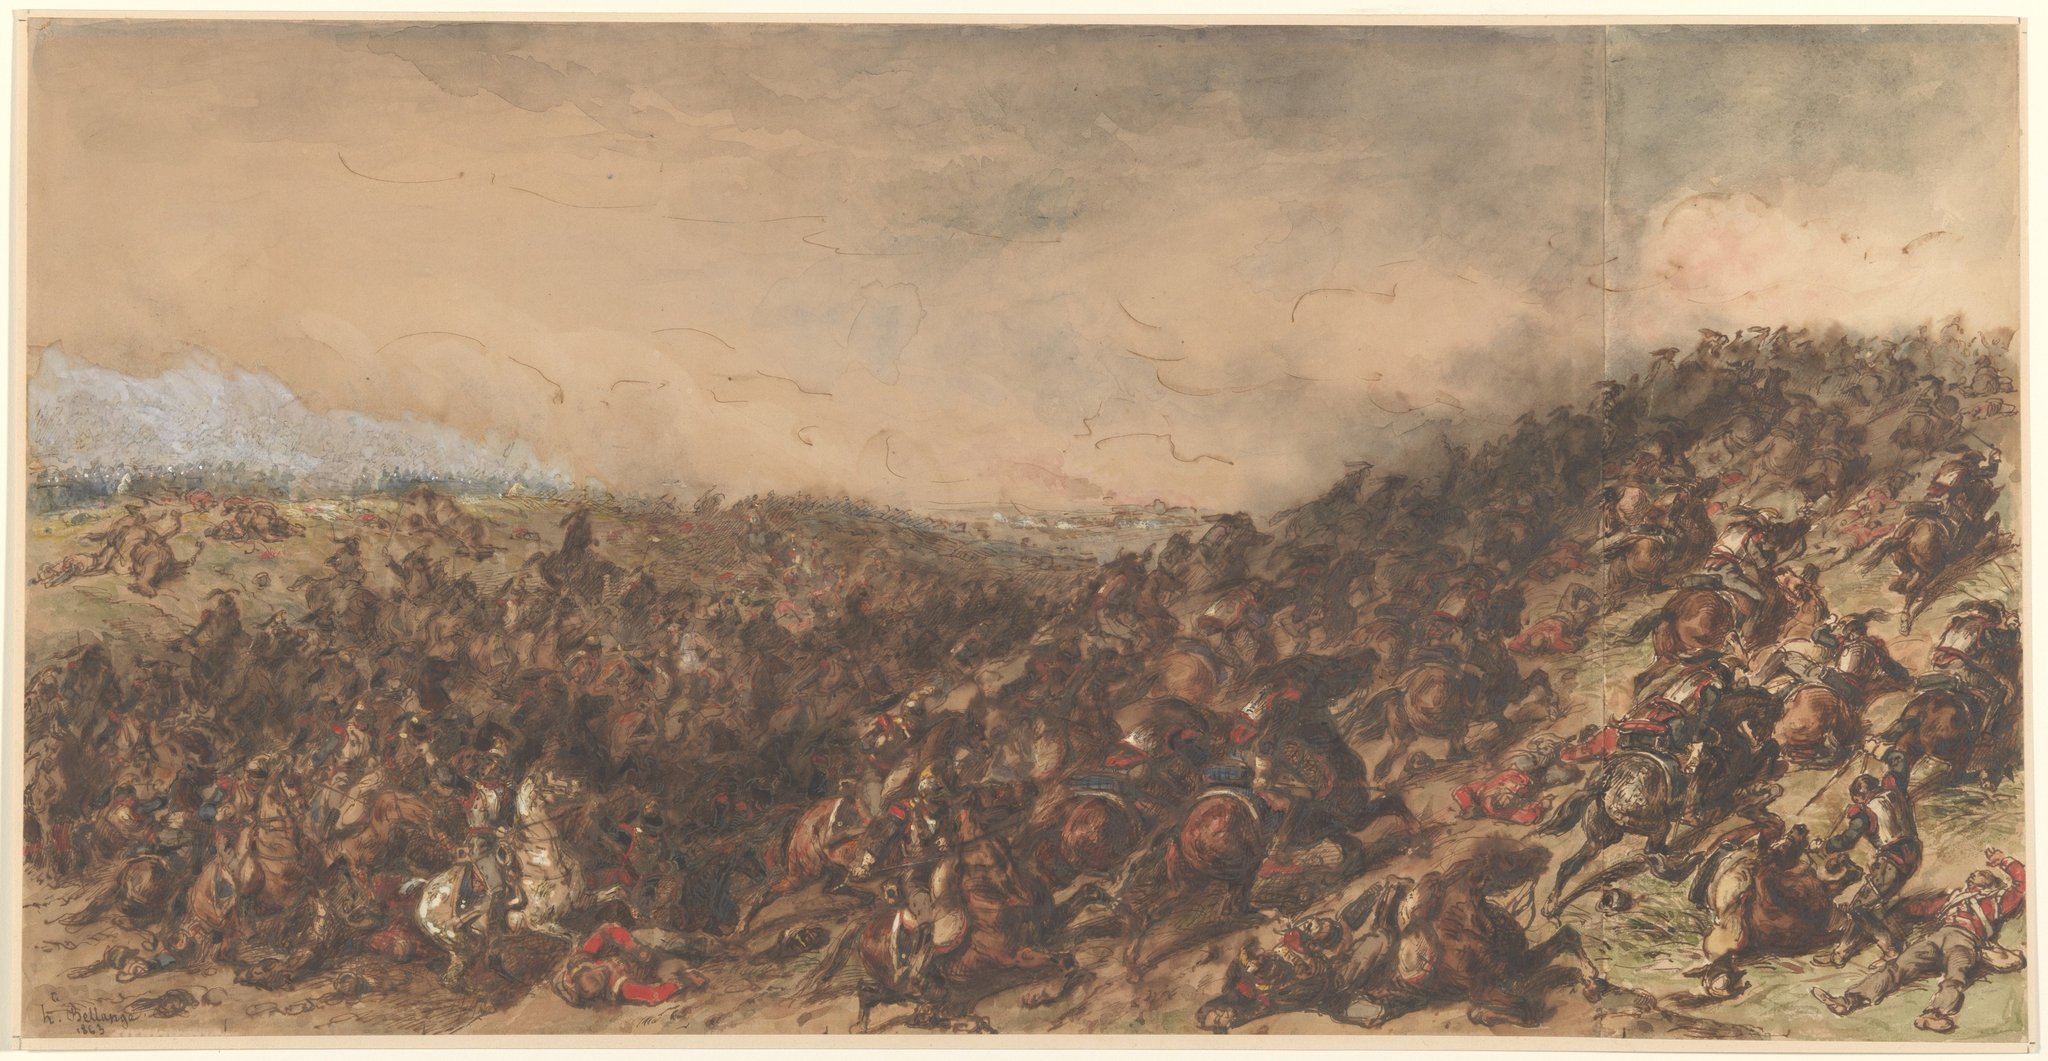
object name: drawing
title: Battle Scene (Waterloo)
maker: hippolyte bellangé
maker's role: artist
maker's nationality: french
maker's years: 1800-1866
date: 1815-1866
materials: chalk, gouache, ink, watercolor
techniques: pen, wash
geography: france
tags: battles,soldiers,weapons,horses,death